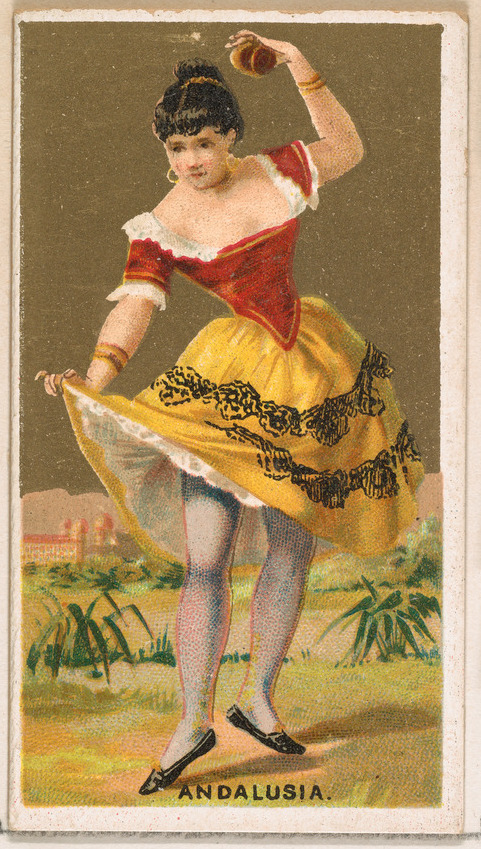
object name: print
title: Andalusia, from the Dancing Girls of the World series (N185) issued by Wm. S. Kimball & Co.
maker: william s. kimball & company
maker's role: publisher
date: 1889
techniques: color lithograph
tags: women,dancing,dancers